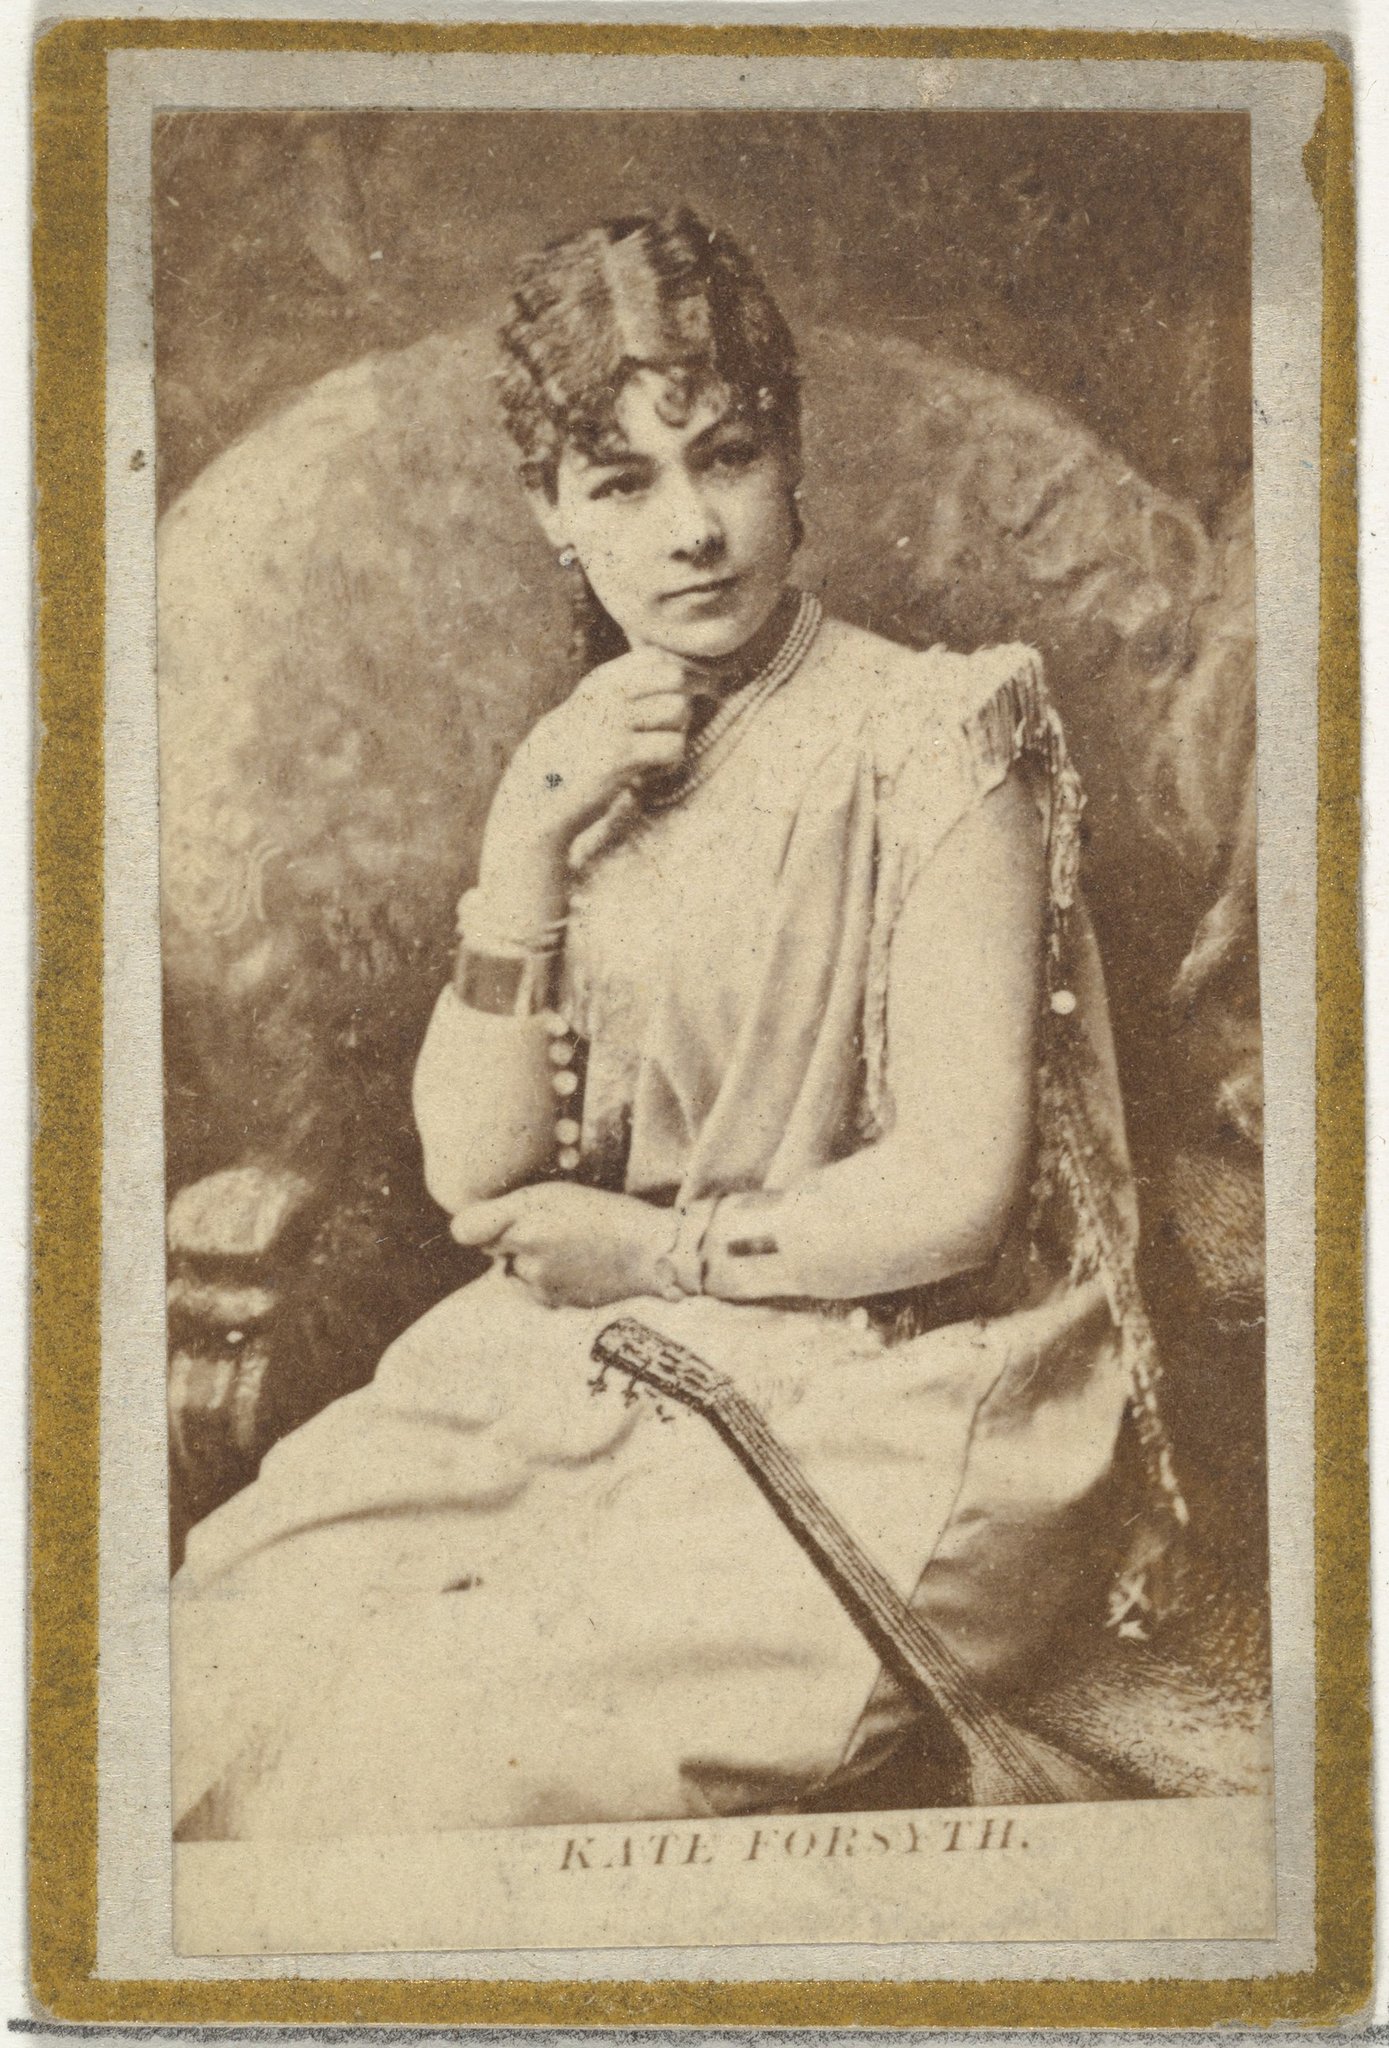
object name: photograph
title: Kate Forsyth, from the Actresses and Celebrities series (N60, Type 2) promoting Little Beauties Cigarettes for Allen & Ginter brand tobacco products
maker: allen & ginter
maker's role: publisher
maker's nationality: american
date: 1887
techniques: albumen silver print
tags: portraits,women,actresses